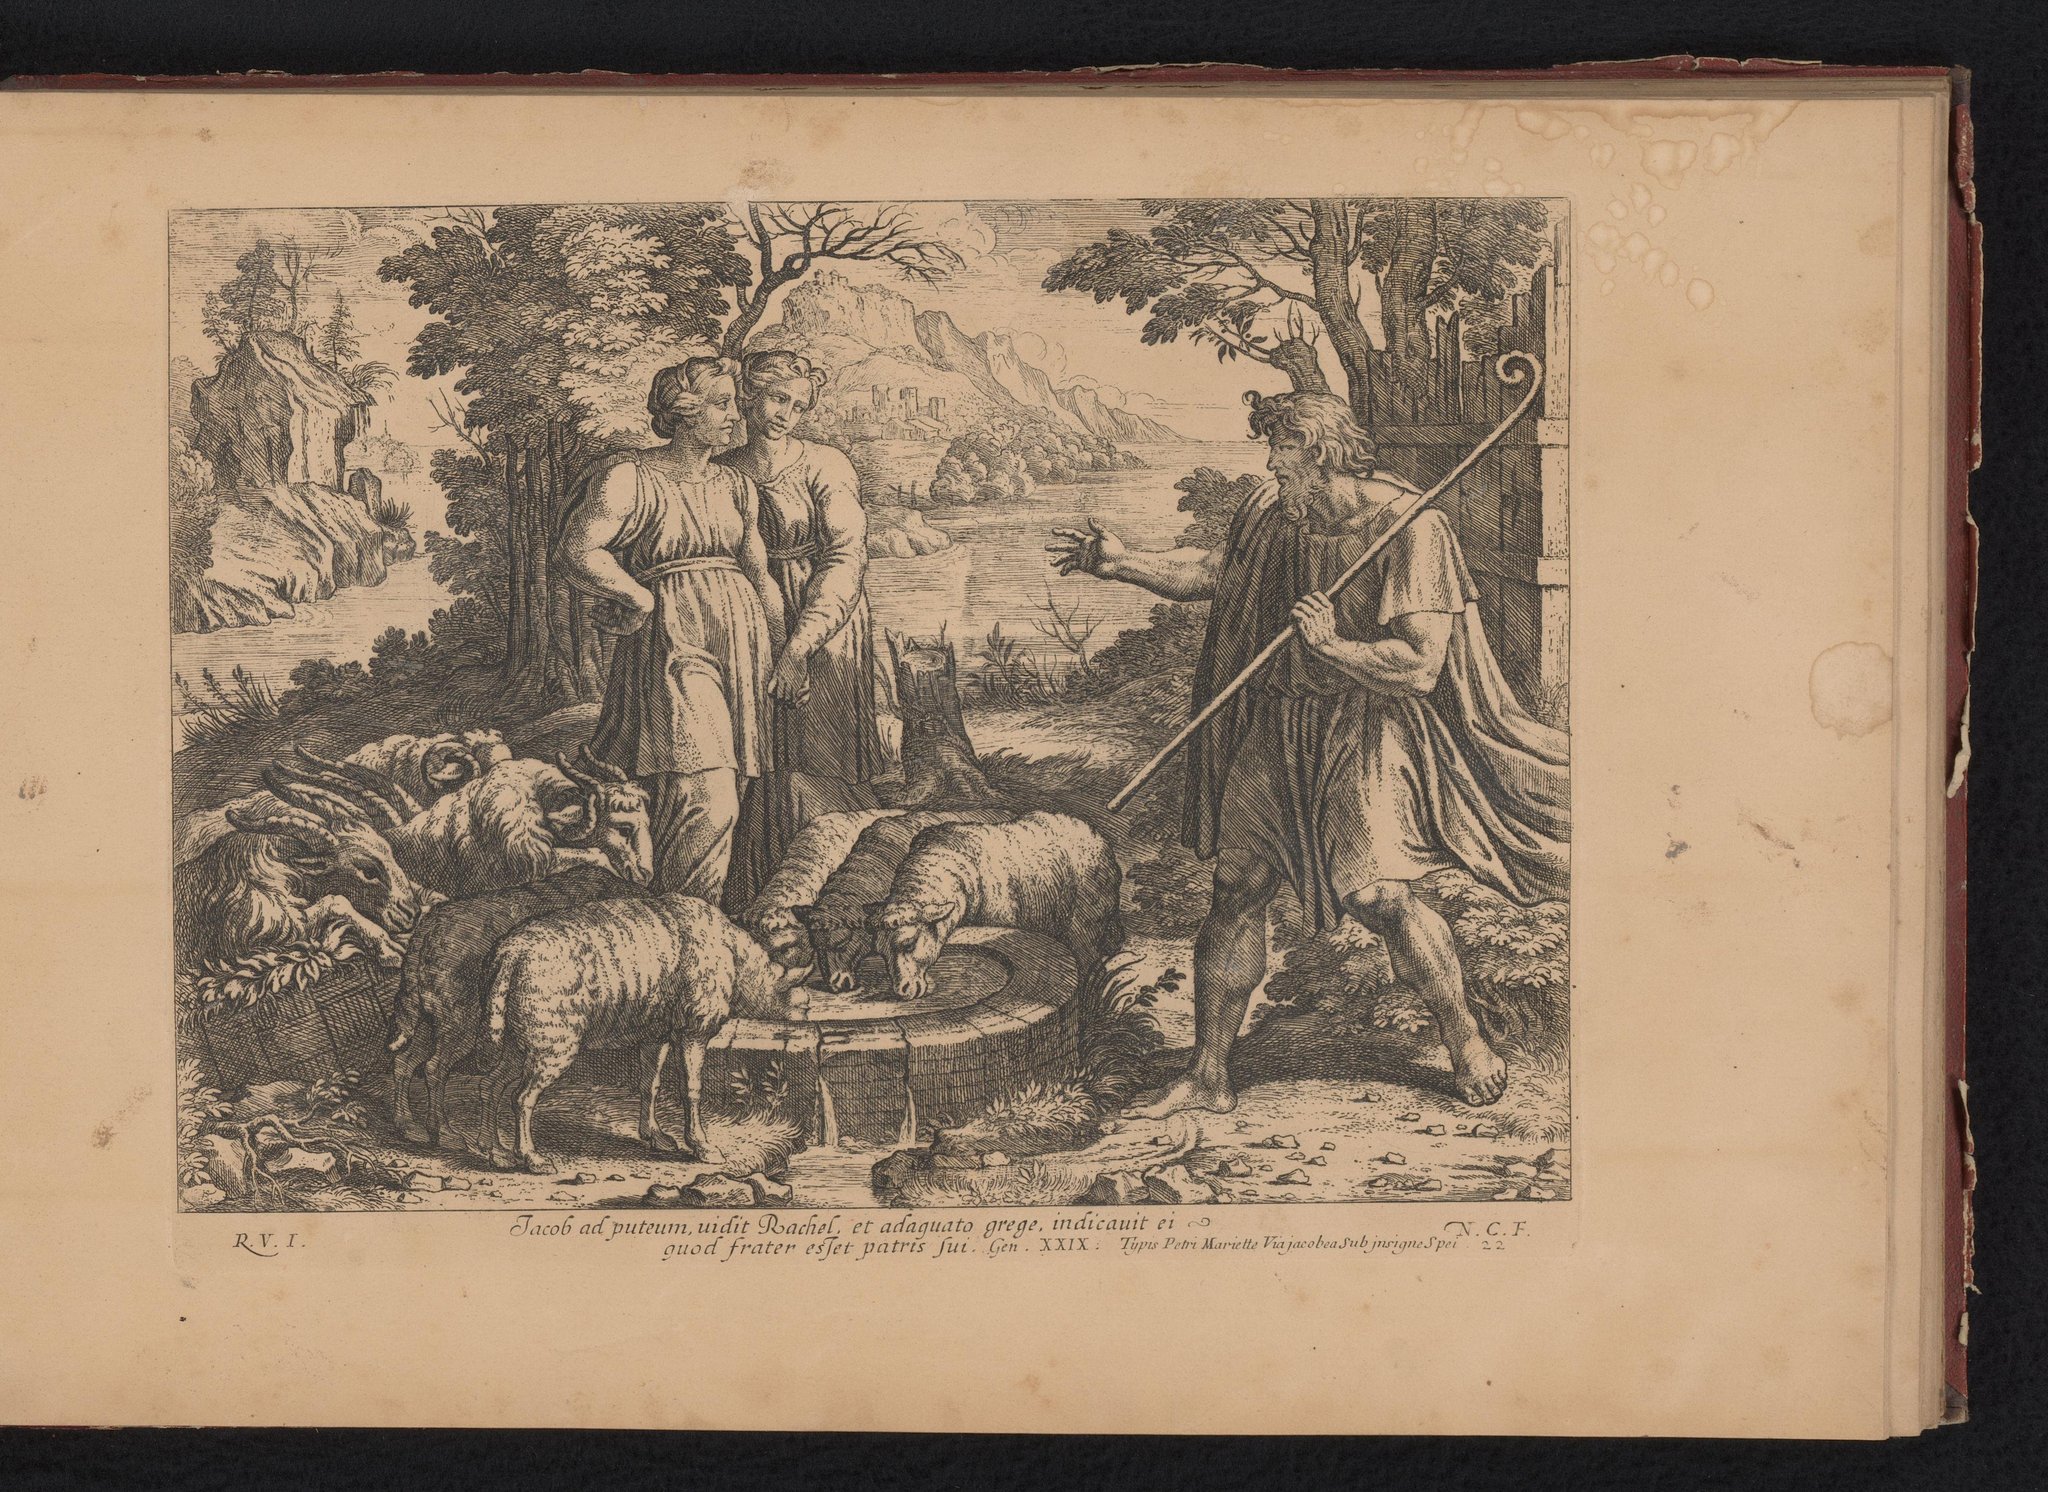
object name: album leaf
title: Jakobs droom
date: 1649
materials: paper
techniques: etching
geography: paris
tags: the dream of jacob: while sleeping on the ground with a stone for pillow jacob sees a ladder reaching from earth to heaven with angels going up and down; usually with god at the top of the ladder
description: Deze prent maakt deel uit van een album.